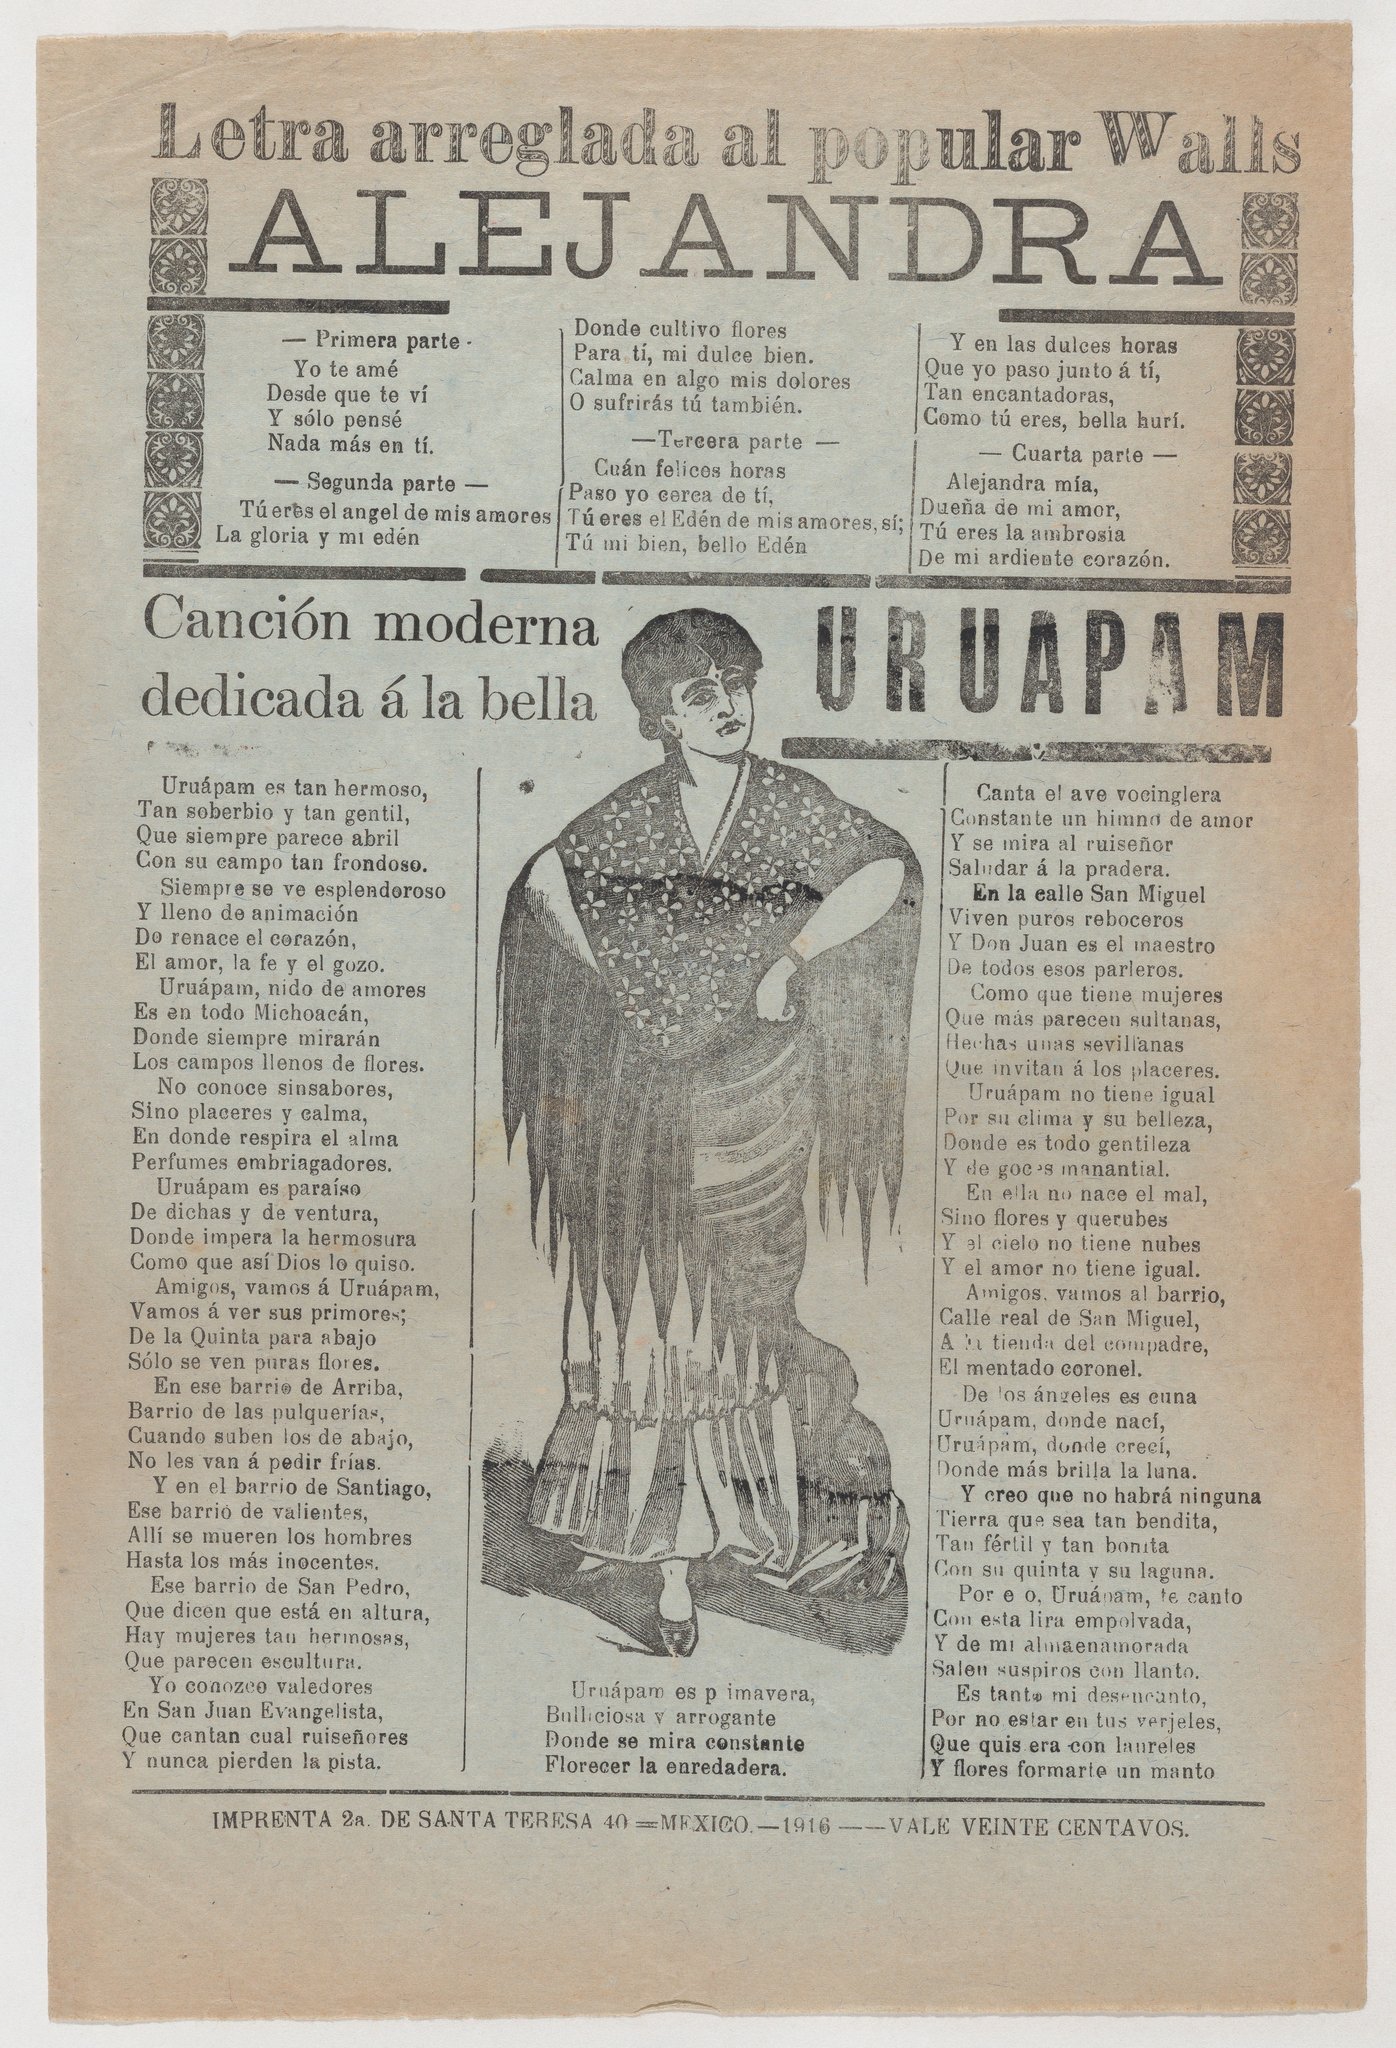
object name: print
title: Broadsheet with two love ballads about desirable women, a woman wearing a shawl and a skirt with her hands placed on her hips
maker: josé guadalupe posada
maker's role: artist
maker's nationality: mexican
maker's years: 1852-1913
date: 1916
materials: metal, paper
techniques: engraving, letterpress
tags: women